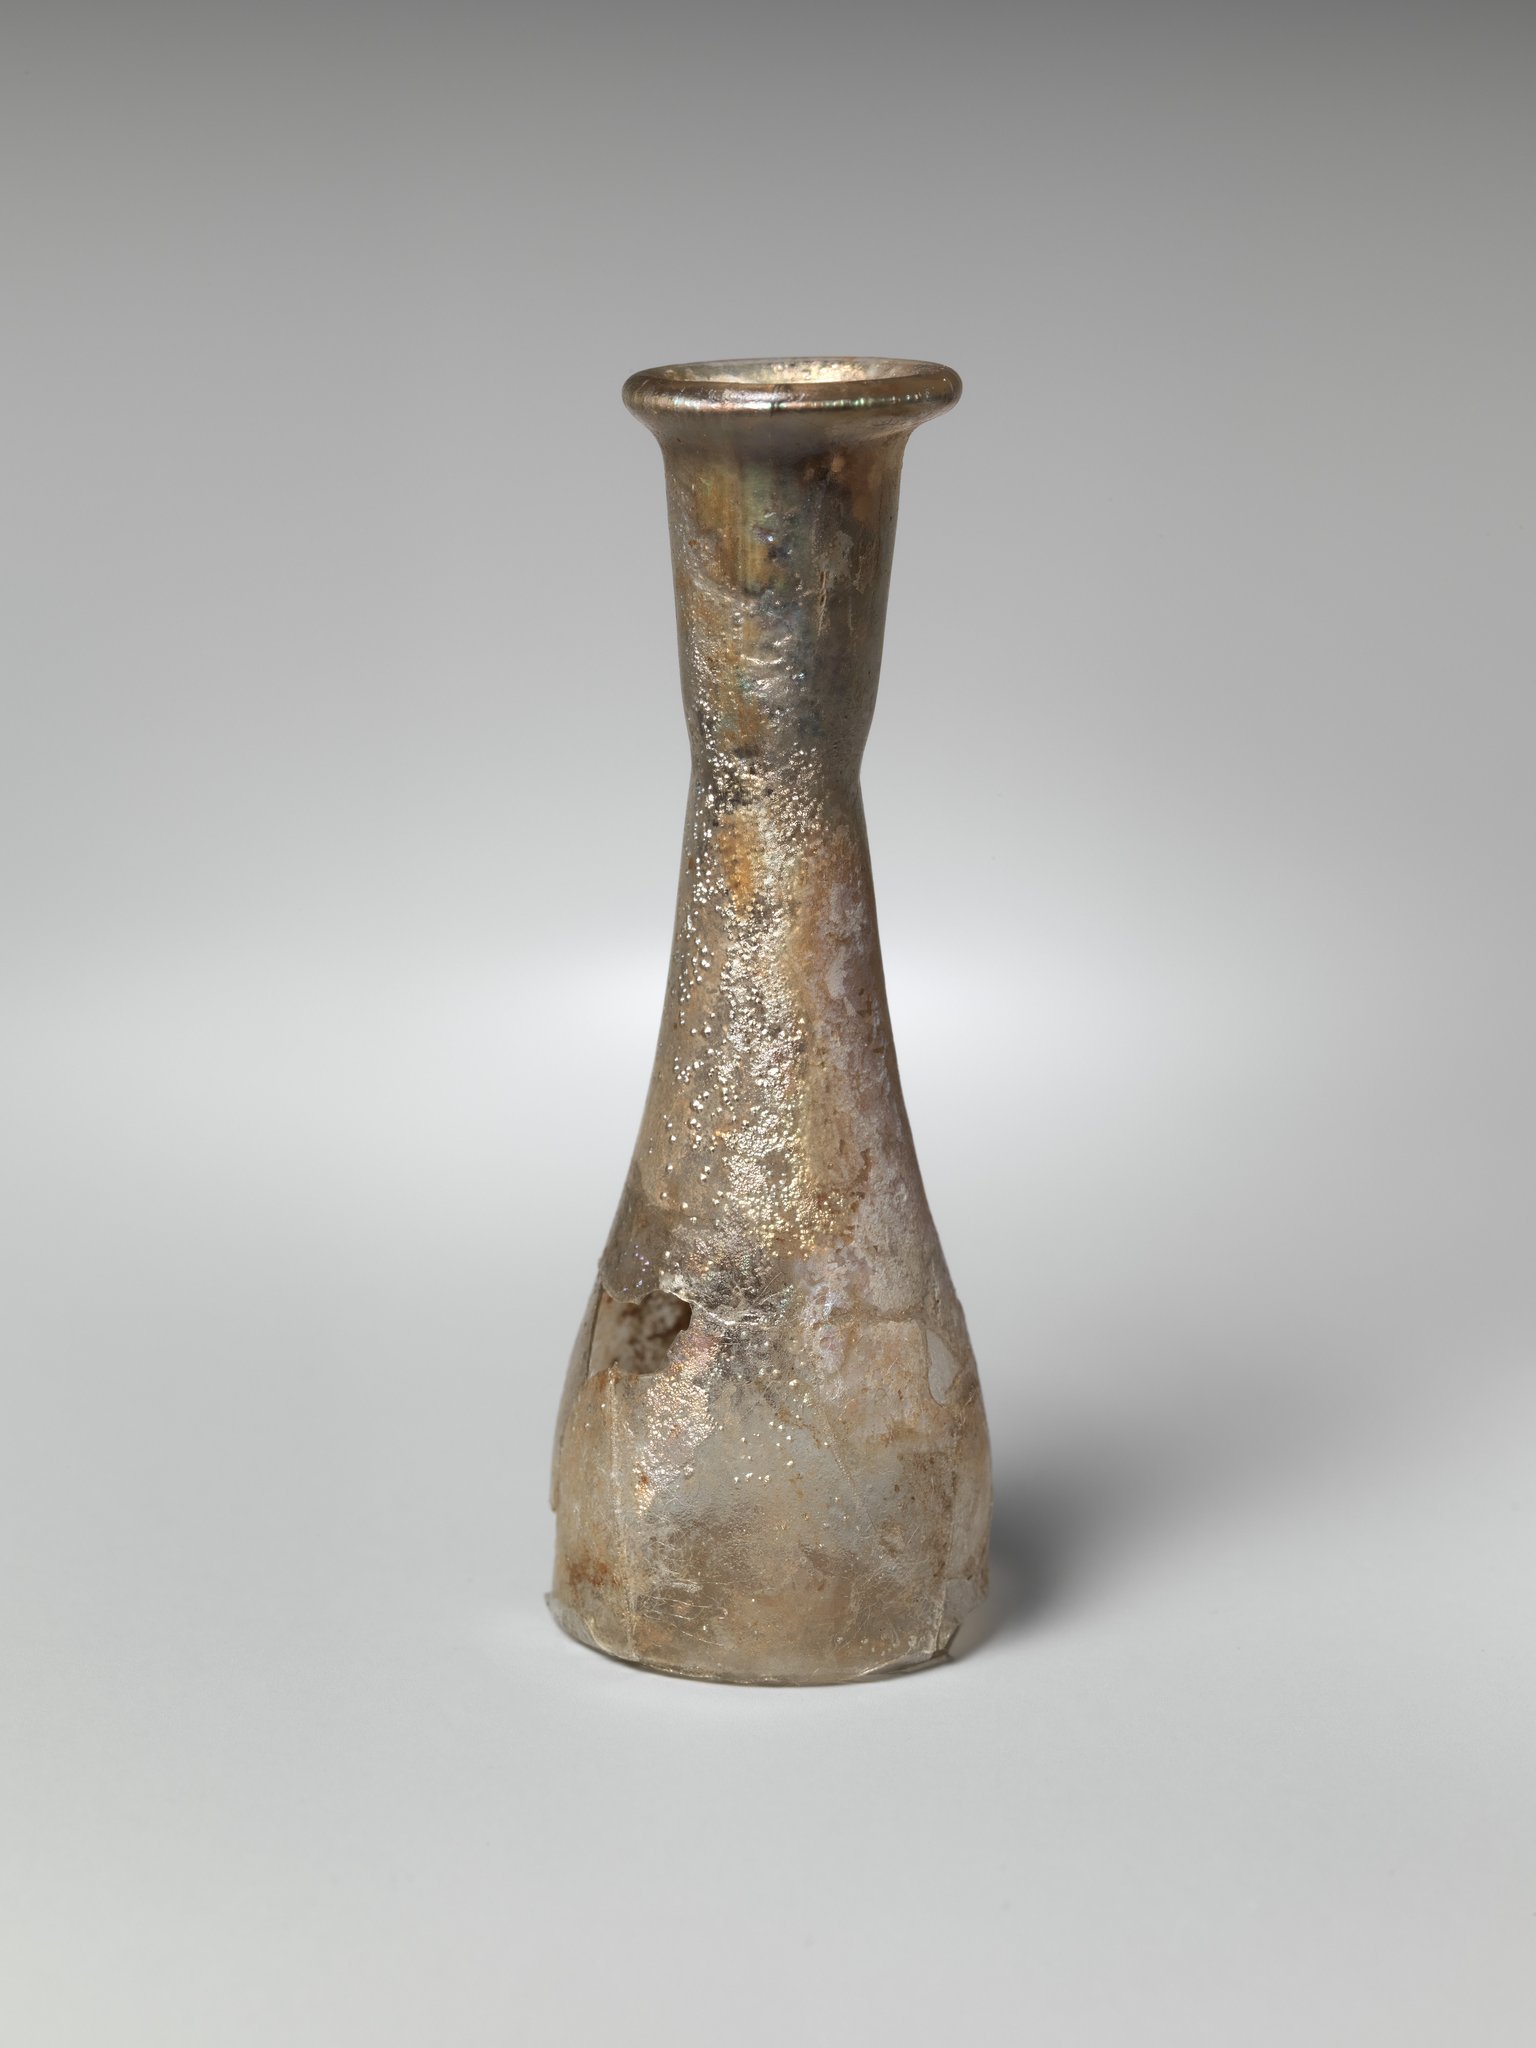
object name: perfume bottle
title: Glass perfume bottle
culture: roman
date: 1-200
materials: glass